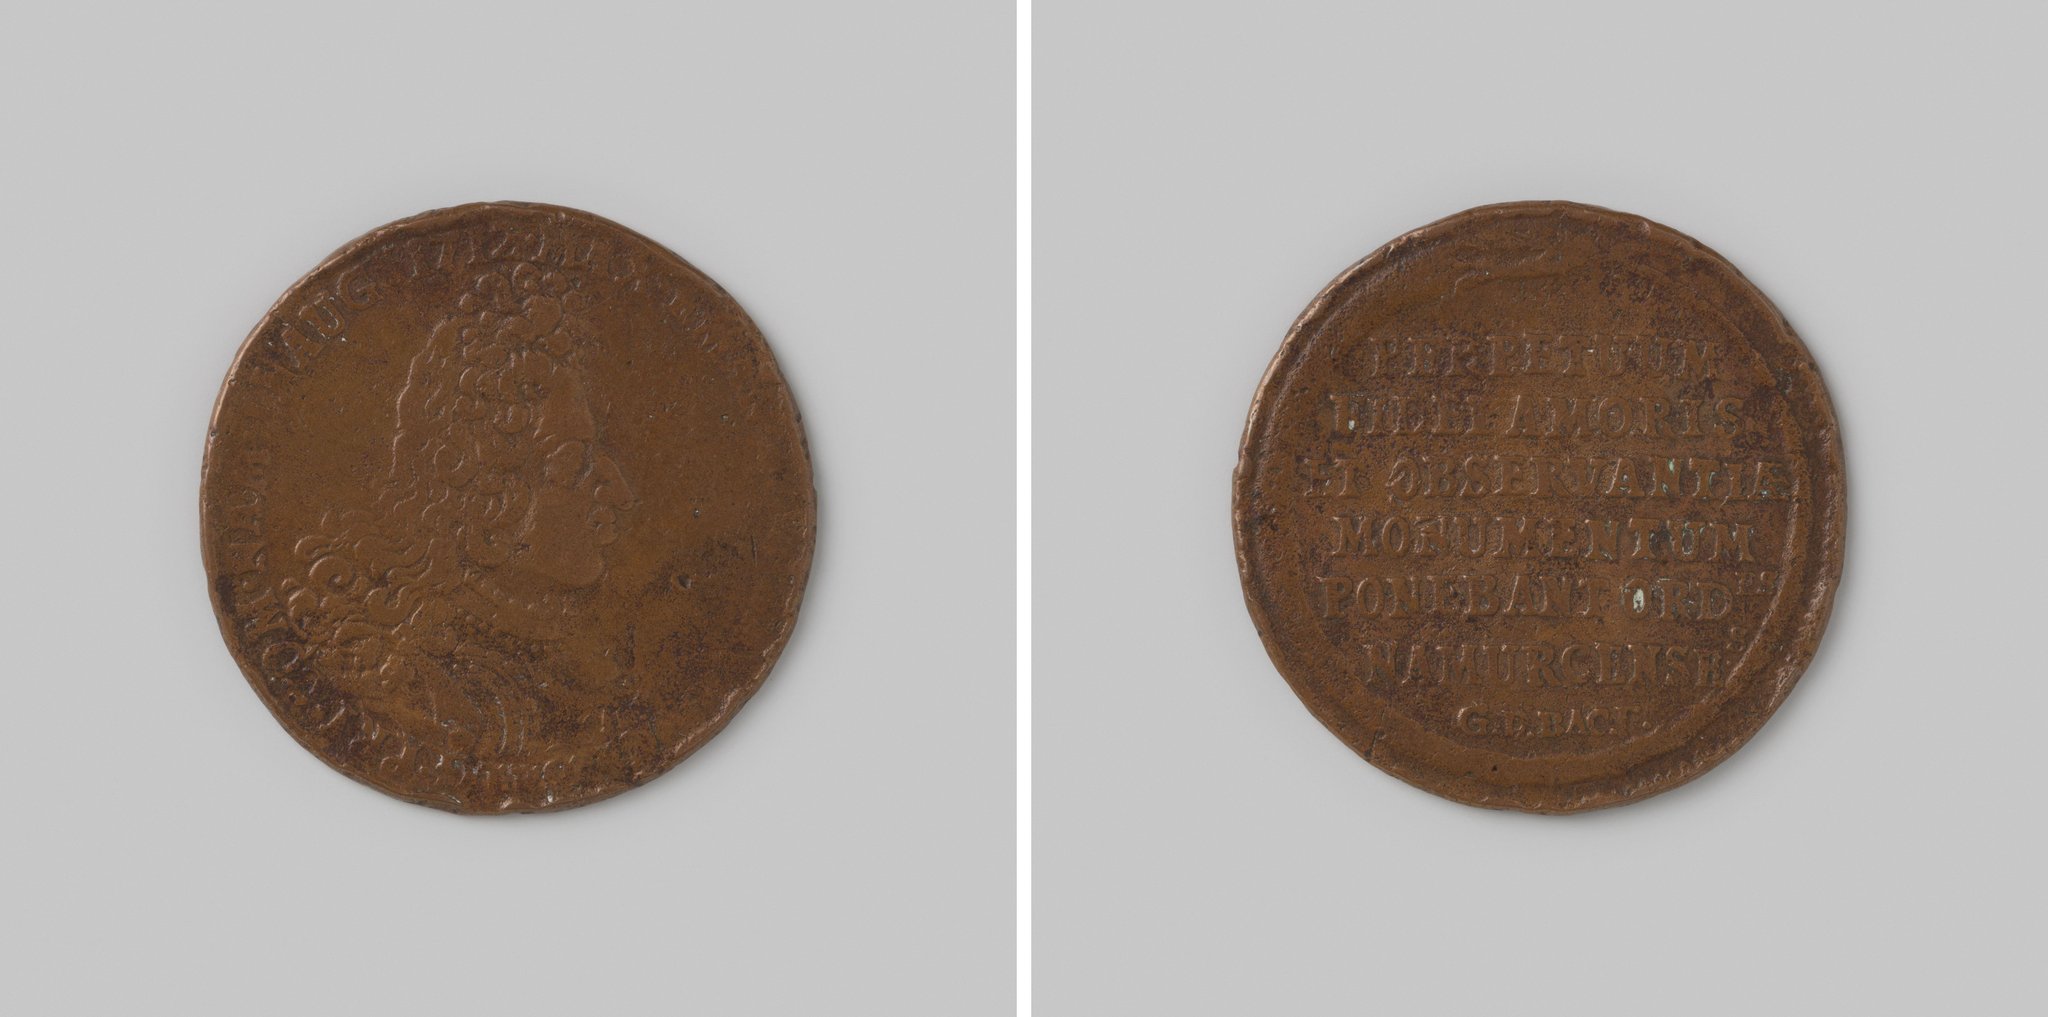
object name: jeton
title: Rekenpenning voor Namen op naam van Maximiliaan Emanuel van Beieren 1712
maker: g. de backer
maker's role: medailleur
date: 1712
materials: copper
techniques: striking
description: Koperen penning, op de voorzijde het borstbeeld van Maximiliaan naar rechts met omschrift, op de keerzijde zes regels tekst binnen een slangenrond.